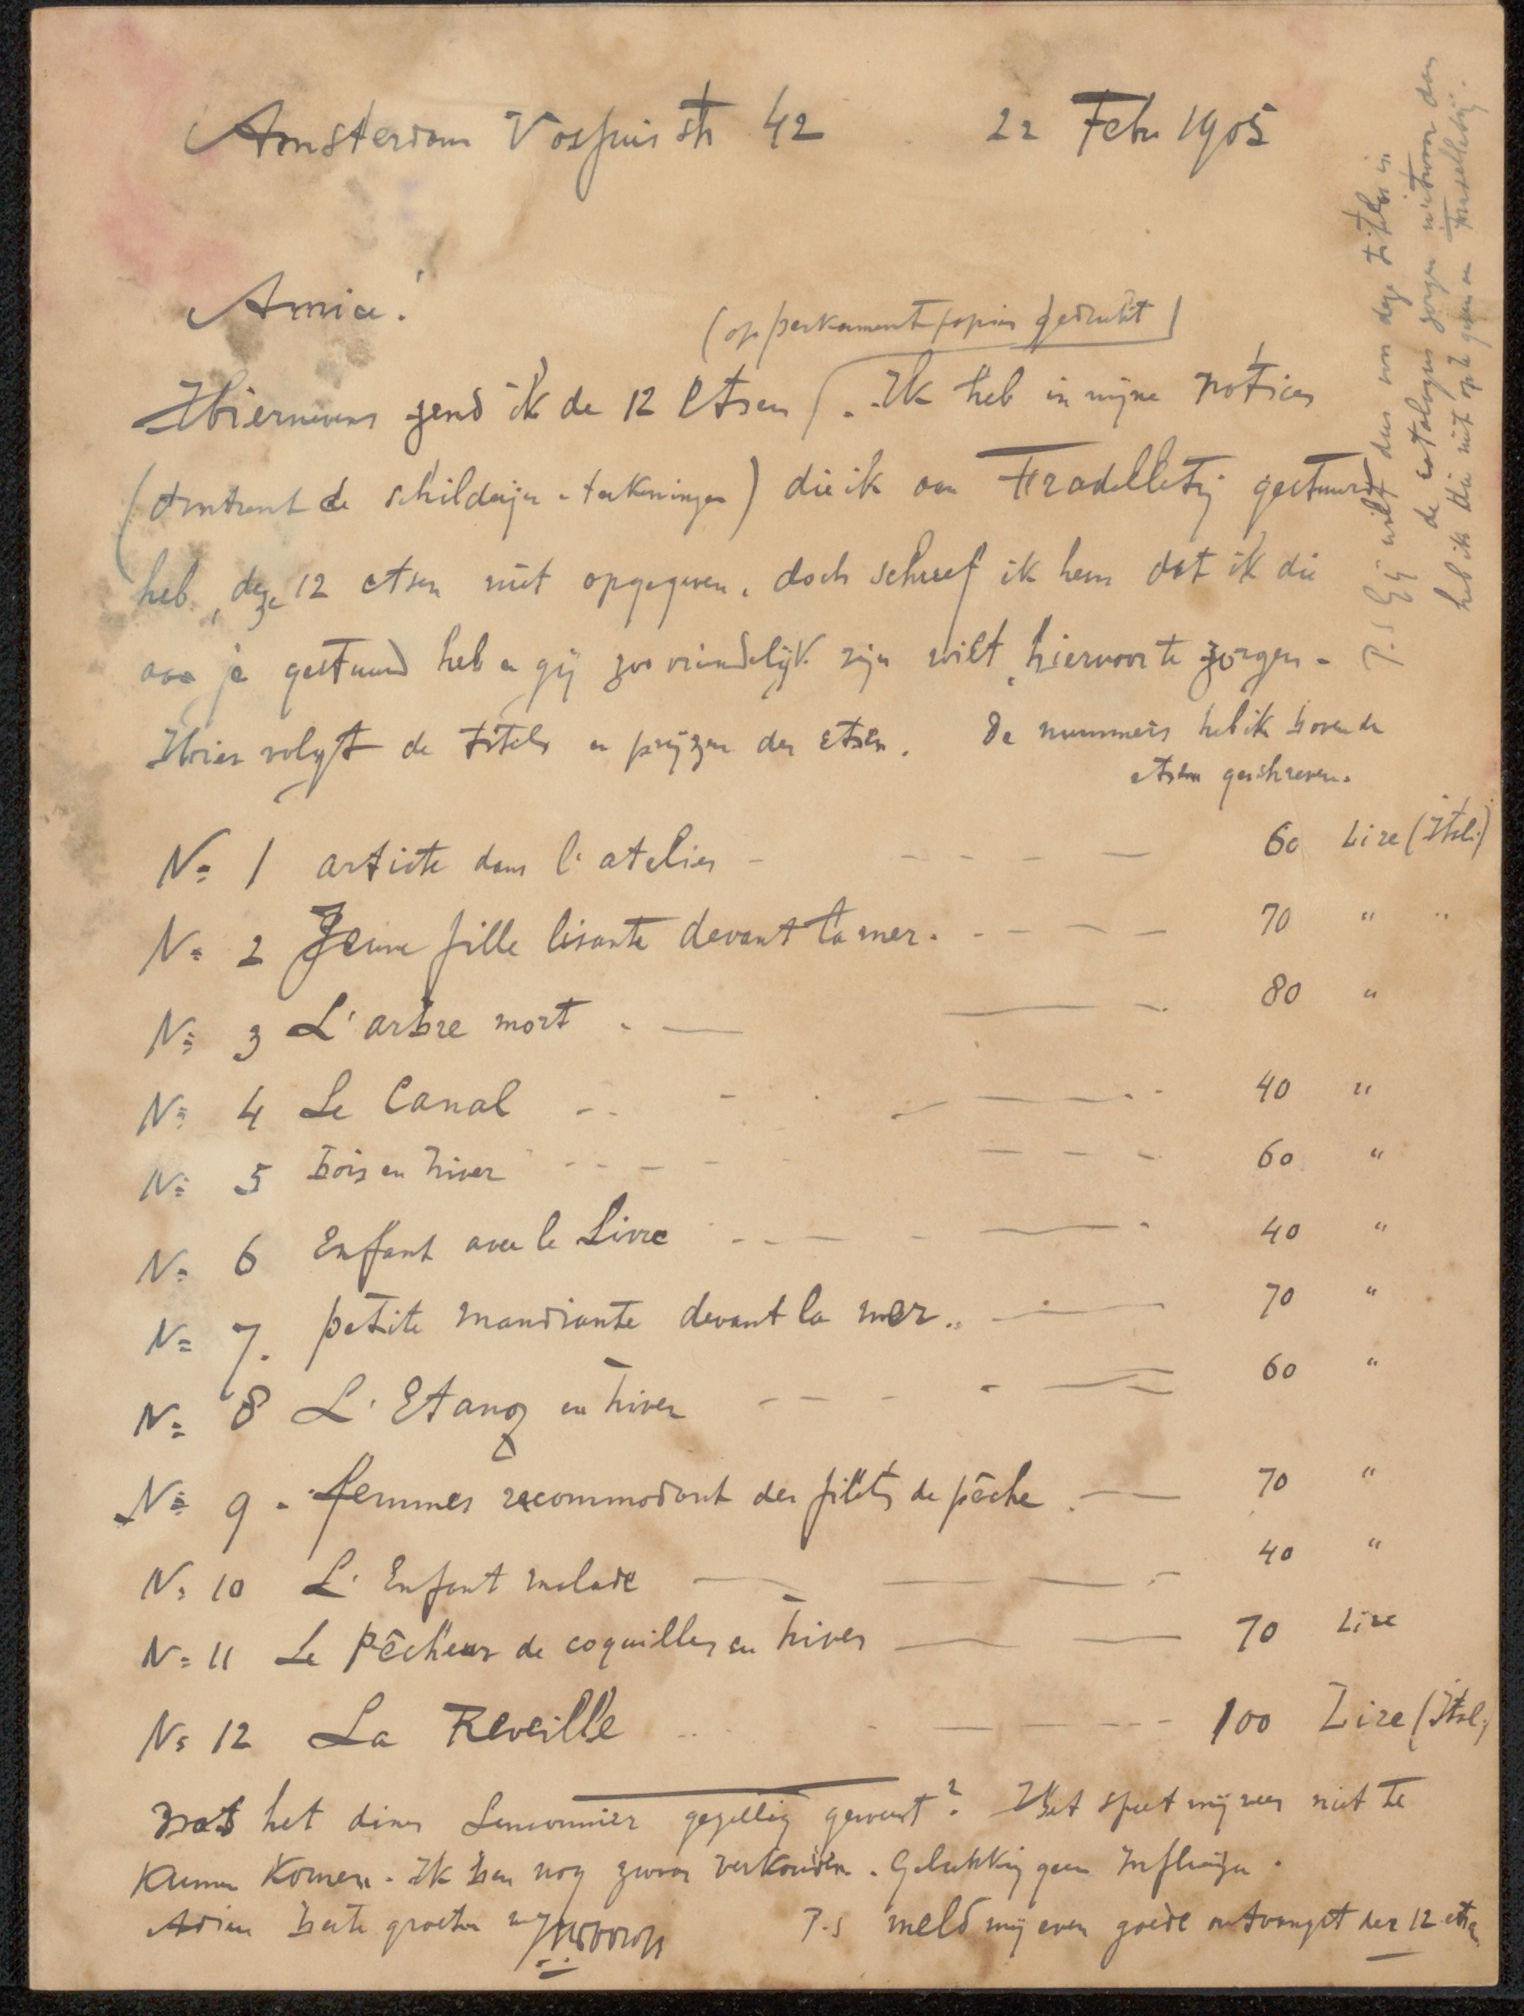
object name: letter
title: Brief aan Philip Zilcken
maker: jan toorop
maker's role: draughtsman, painter, print maker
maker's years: 1858-1928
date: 1905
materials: ink, paper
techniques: pen, writing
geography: amsterdam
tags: camille lemonnier, venice, rome, politician, antonio fradeletto, painter, draughtsman, philip zilcken, the graphic arts, money, printed matter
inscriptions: collector's mark: ‘RPK’, watermark